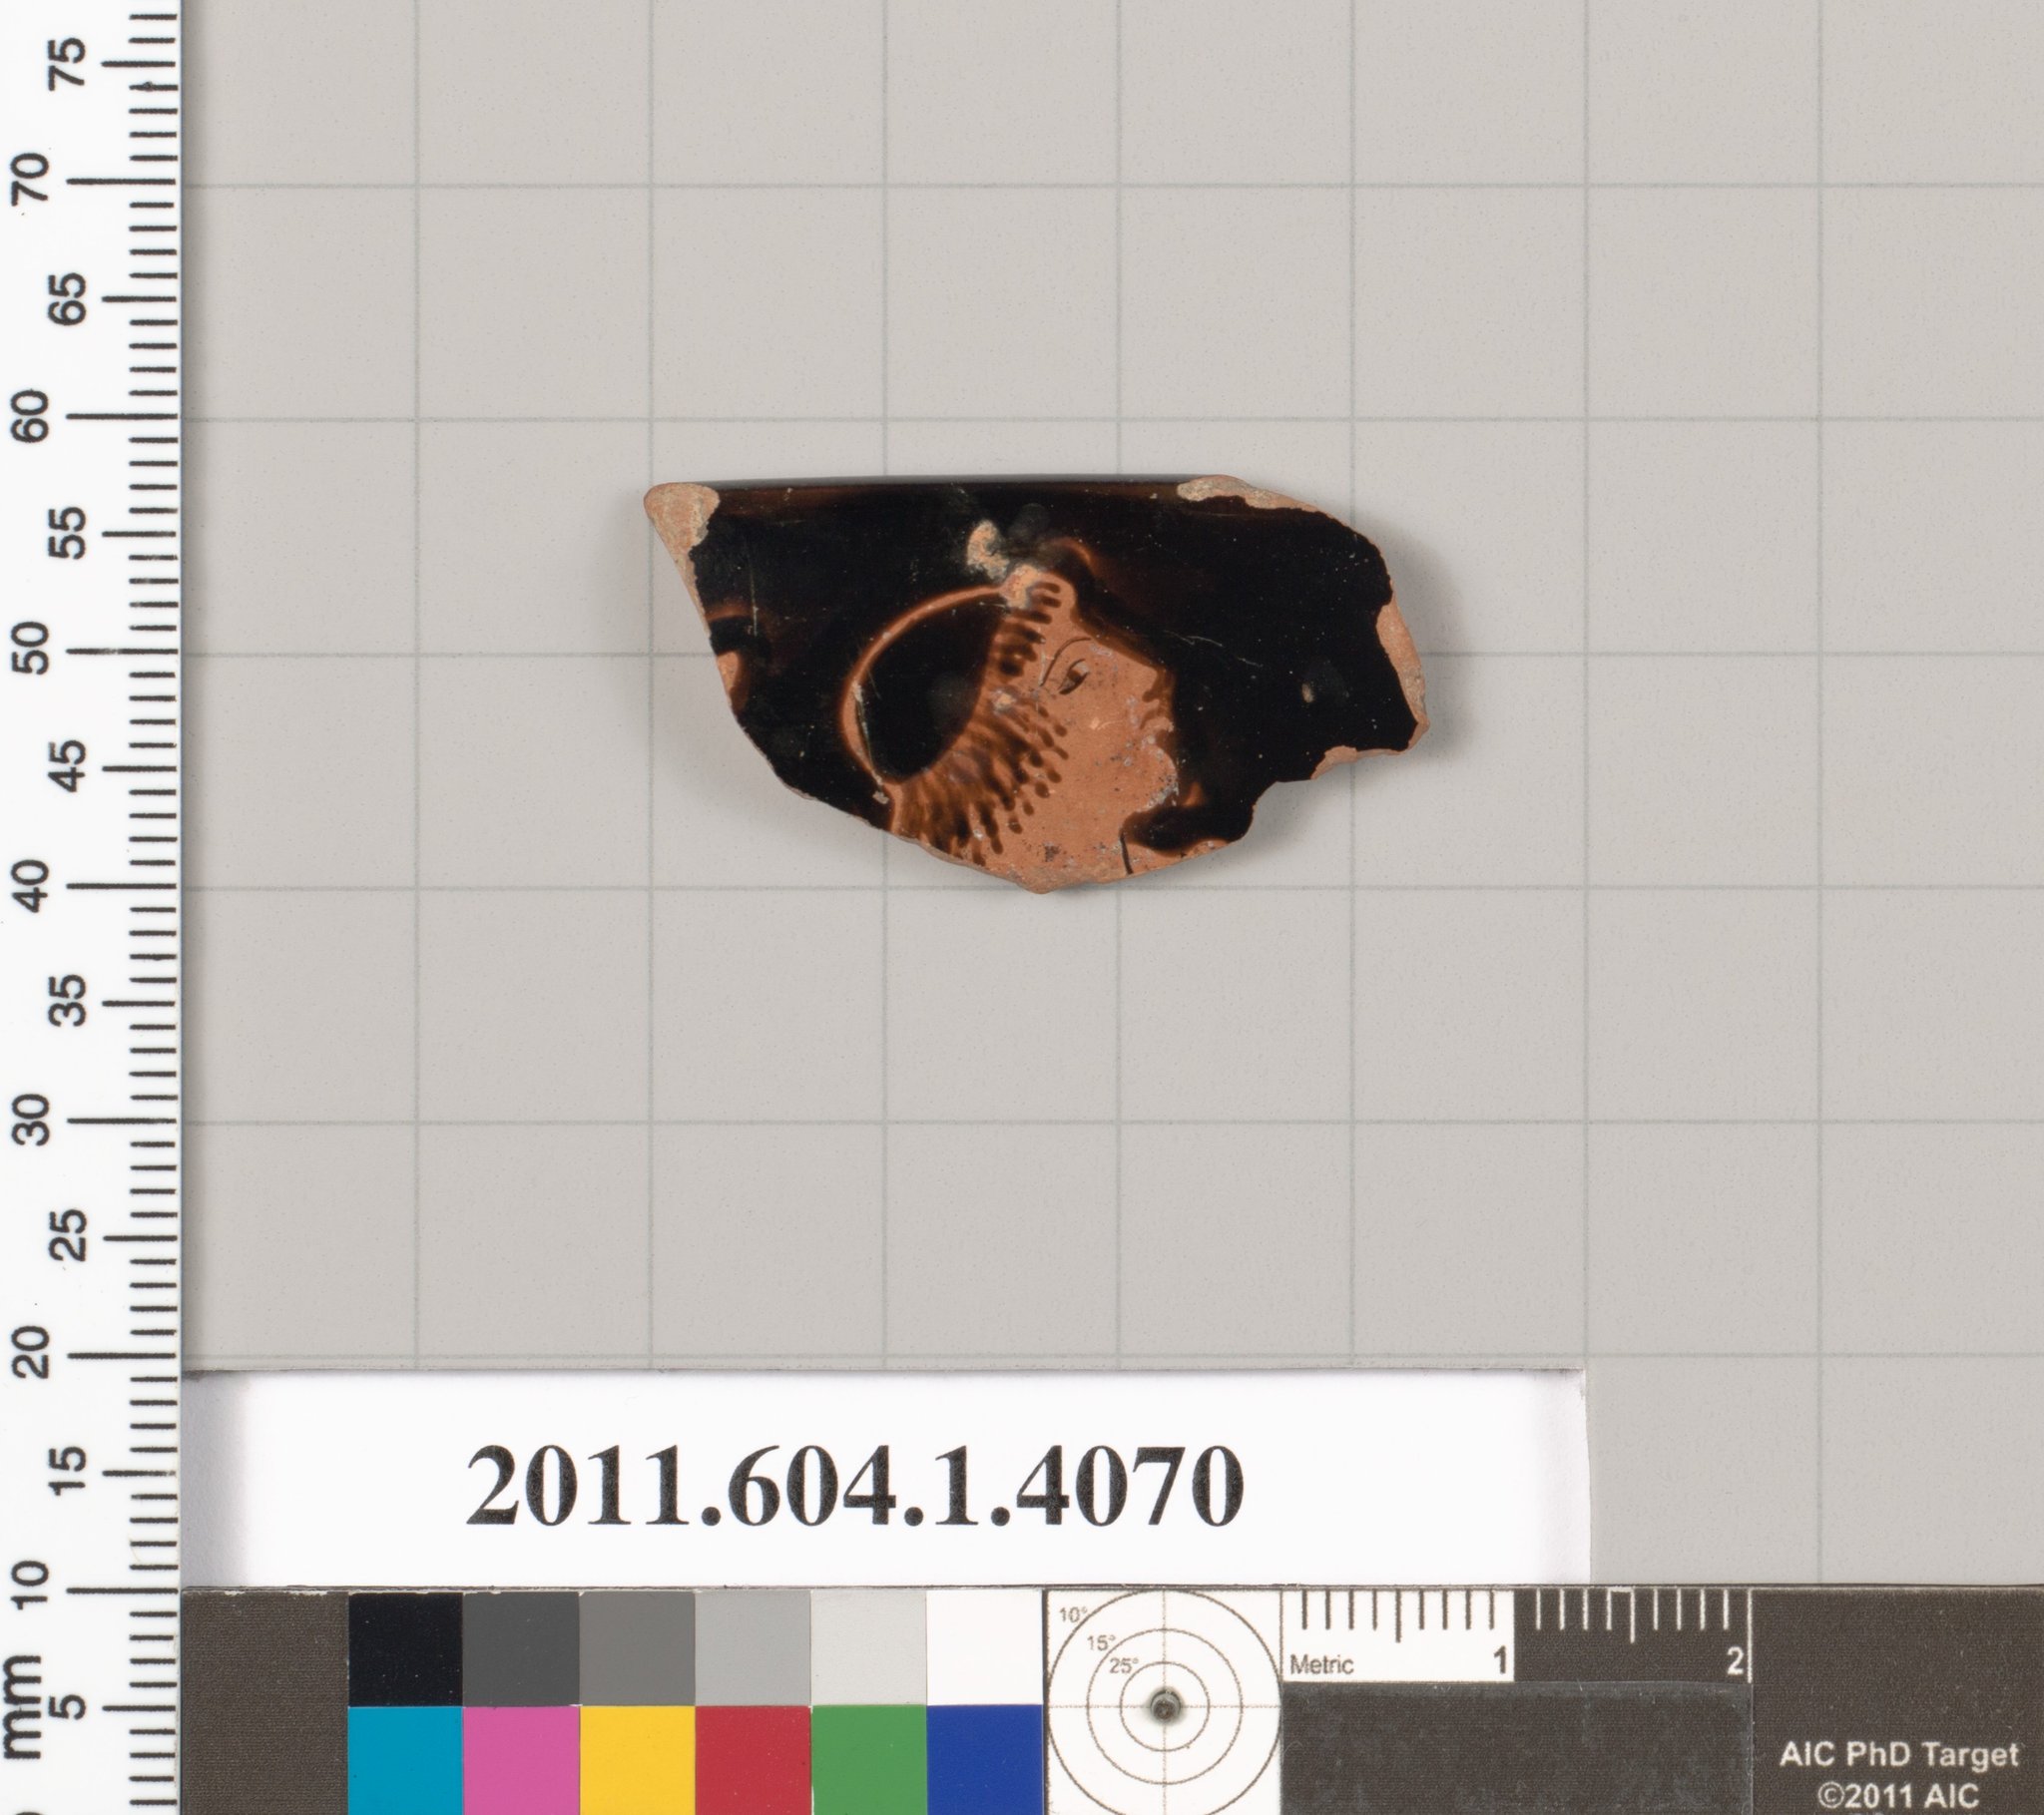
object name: kylix fragment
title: Terracotta rim fragment of a kylix (drinking cup)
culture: greek, attic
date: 470-460 BCE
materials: terracotta